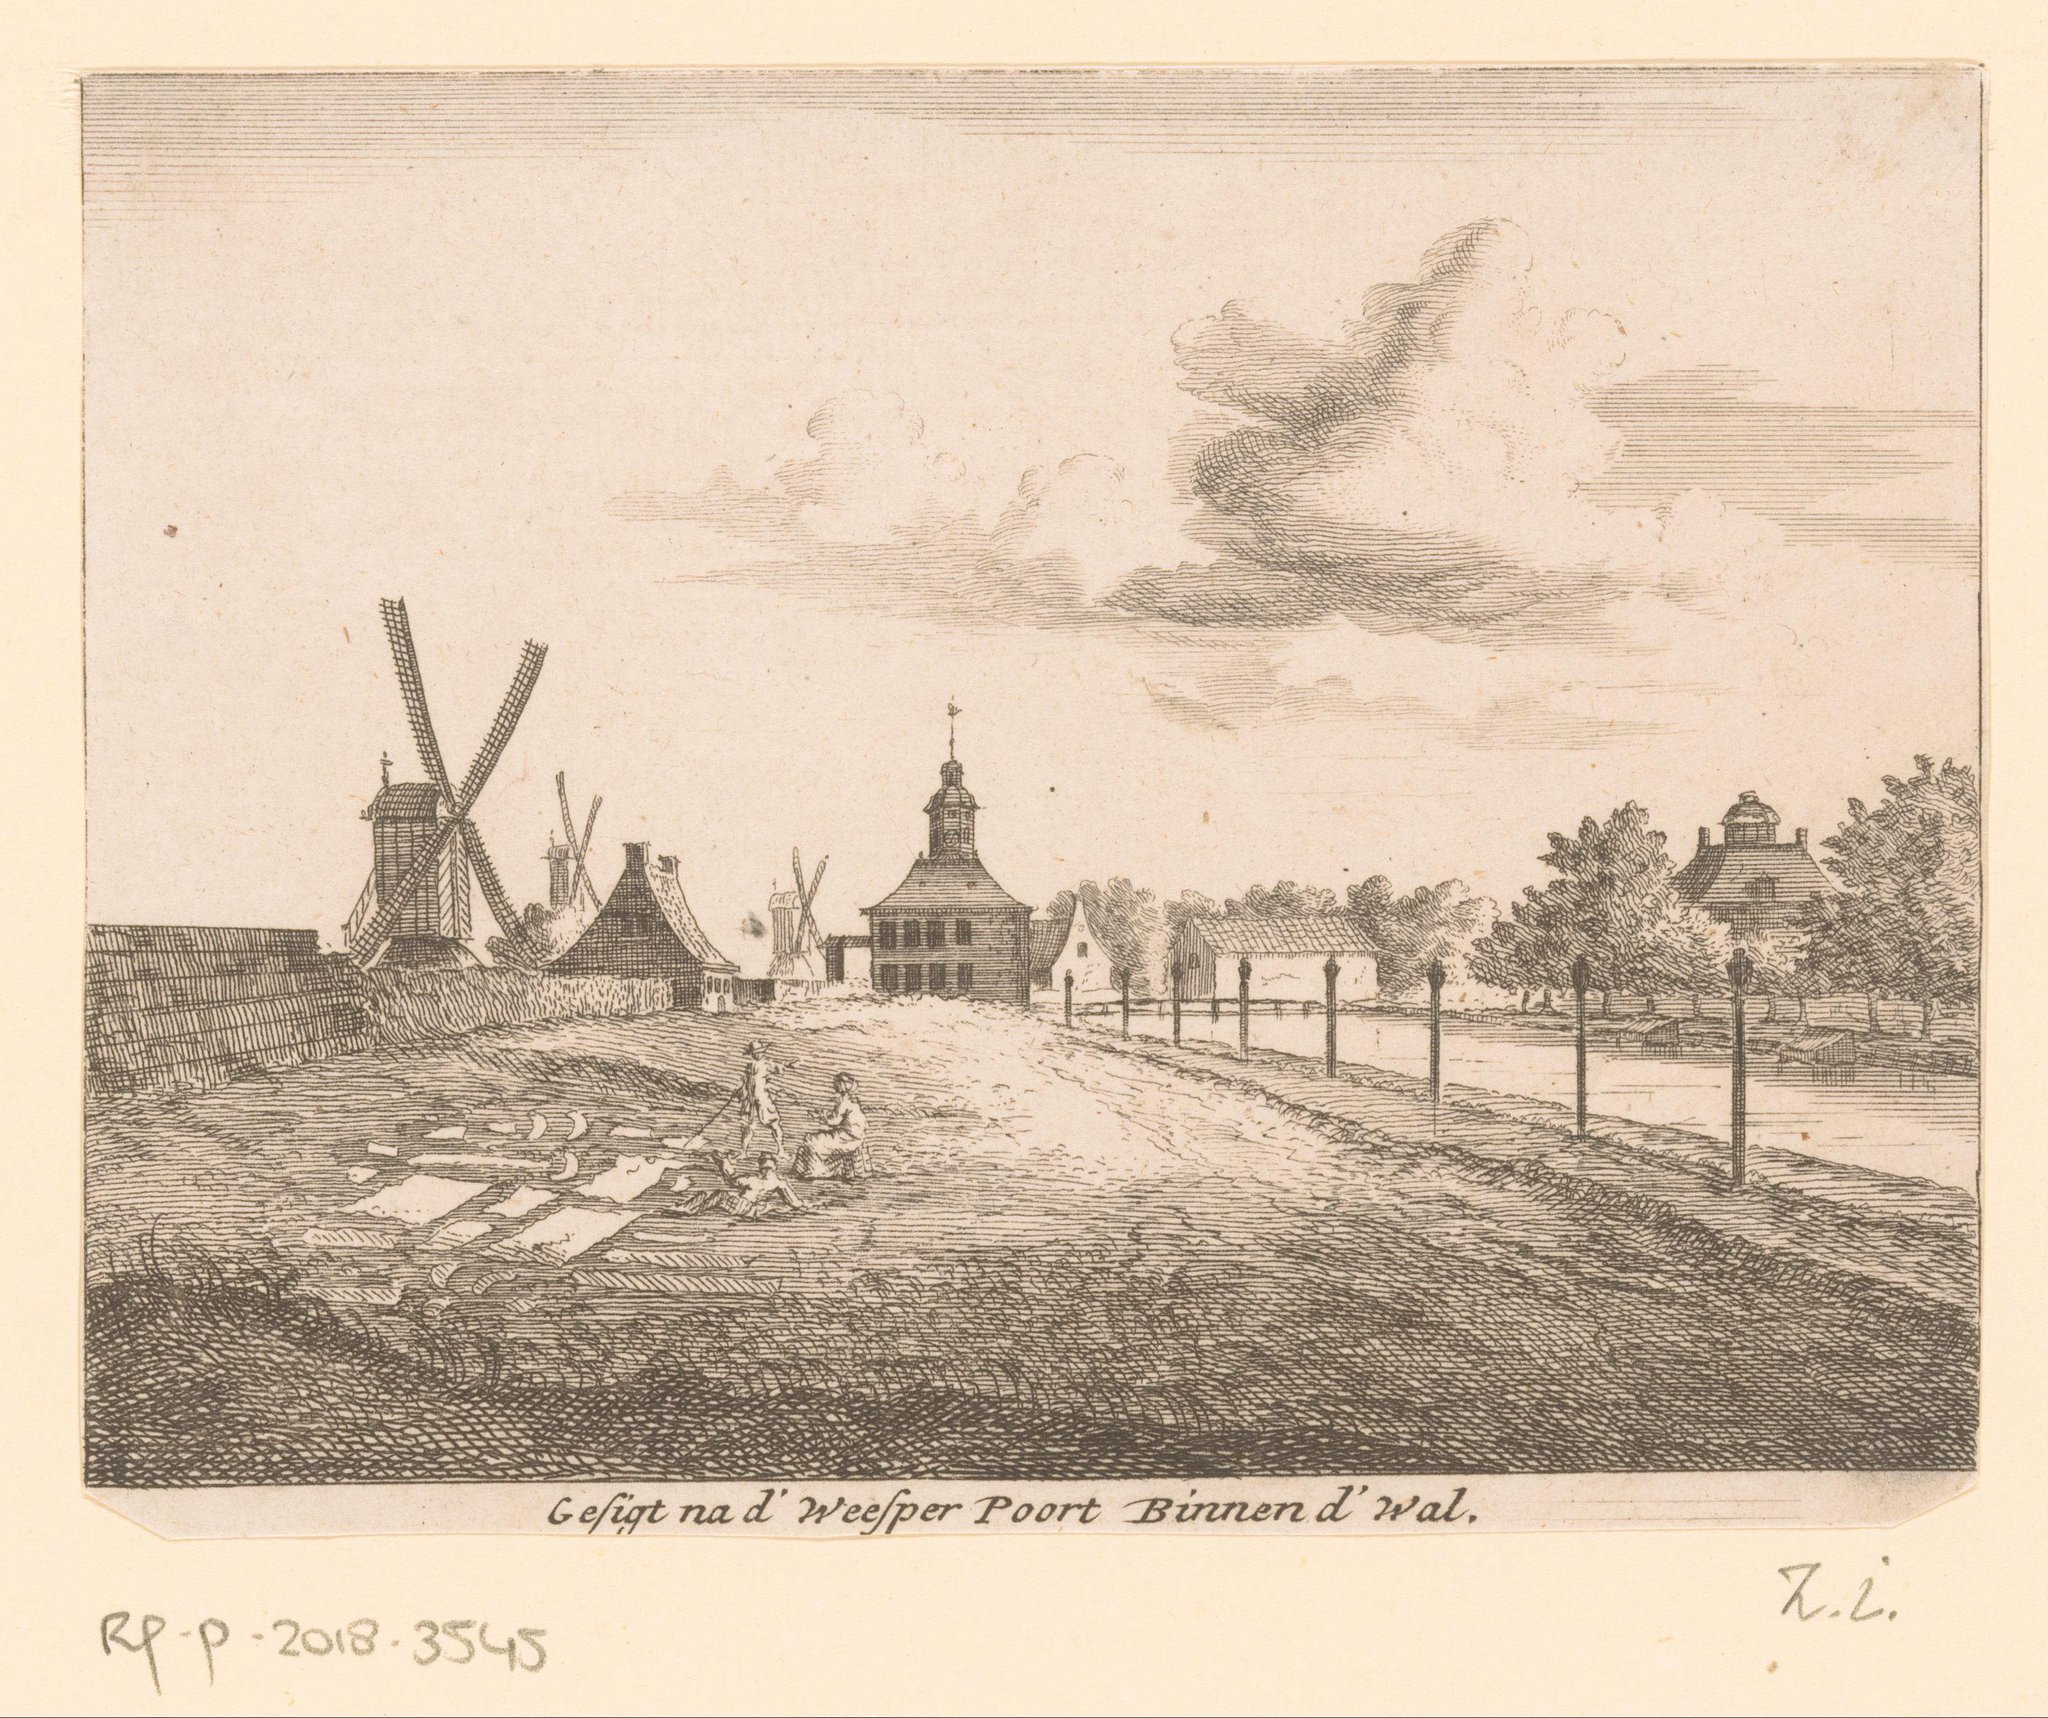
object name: print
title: Gesigt naa d'Weesper Poort binnen d'wal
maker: Anonymous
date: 1650-1750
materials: paper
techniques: etching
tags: bleaching (laundering), windmill in landscape, bridge in city across river, canal, etc., city-gate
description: Gezicht op de Weesperpoort over de Schans, in zuidwestelijke richting. Rechts de Nieuwe Lijnbaansgracht. Linksvoor wordt was gebleekt.